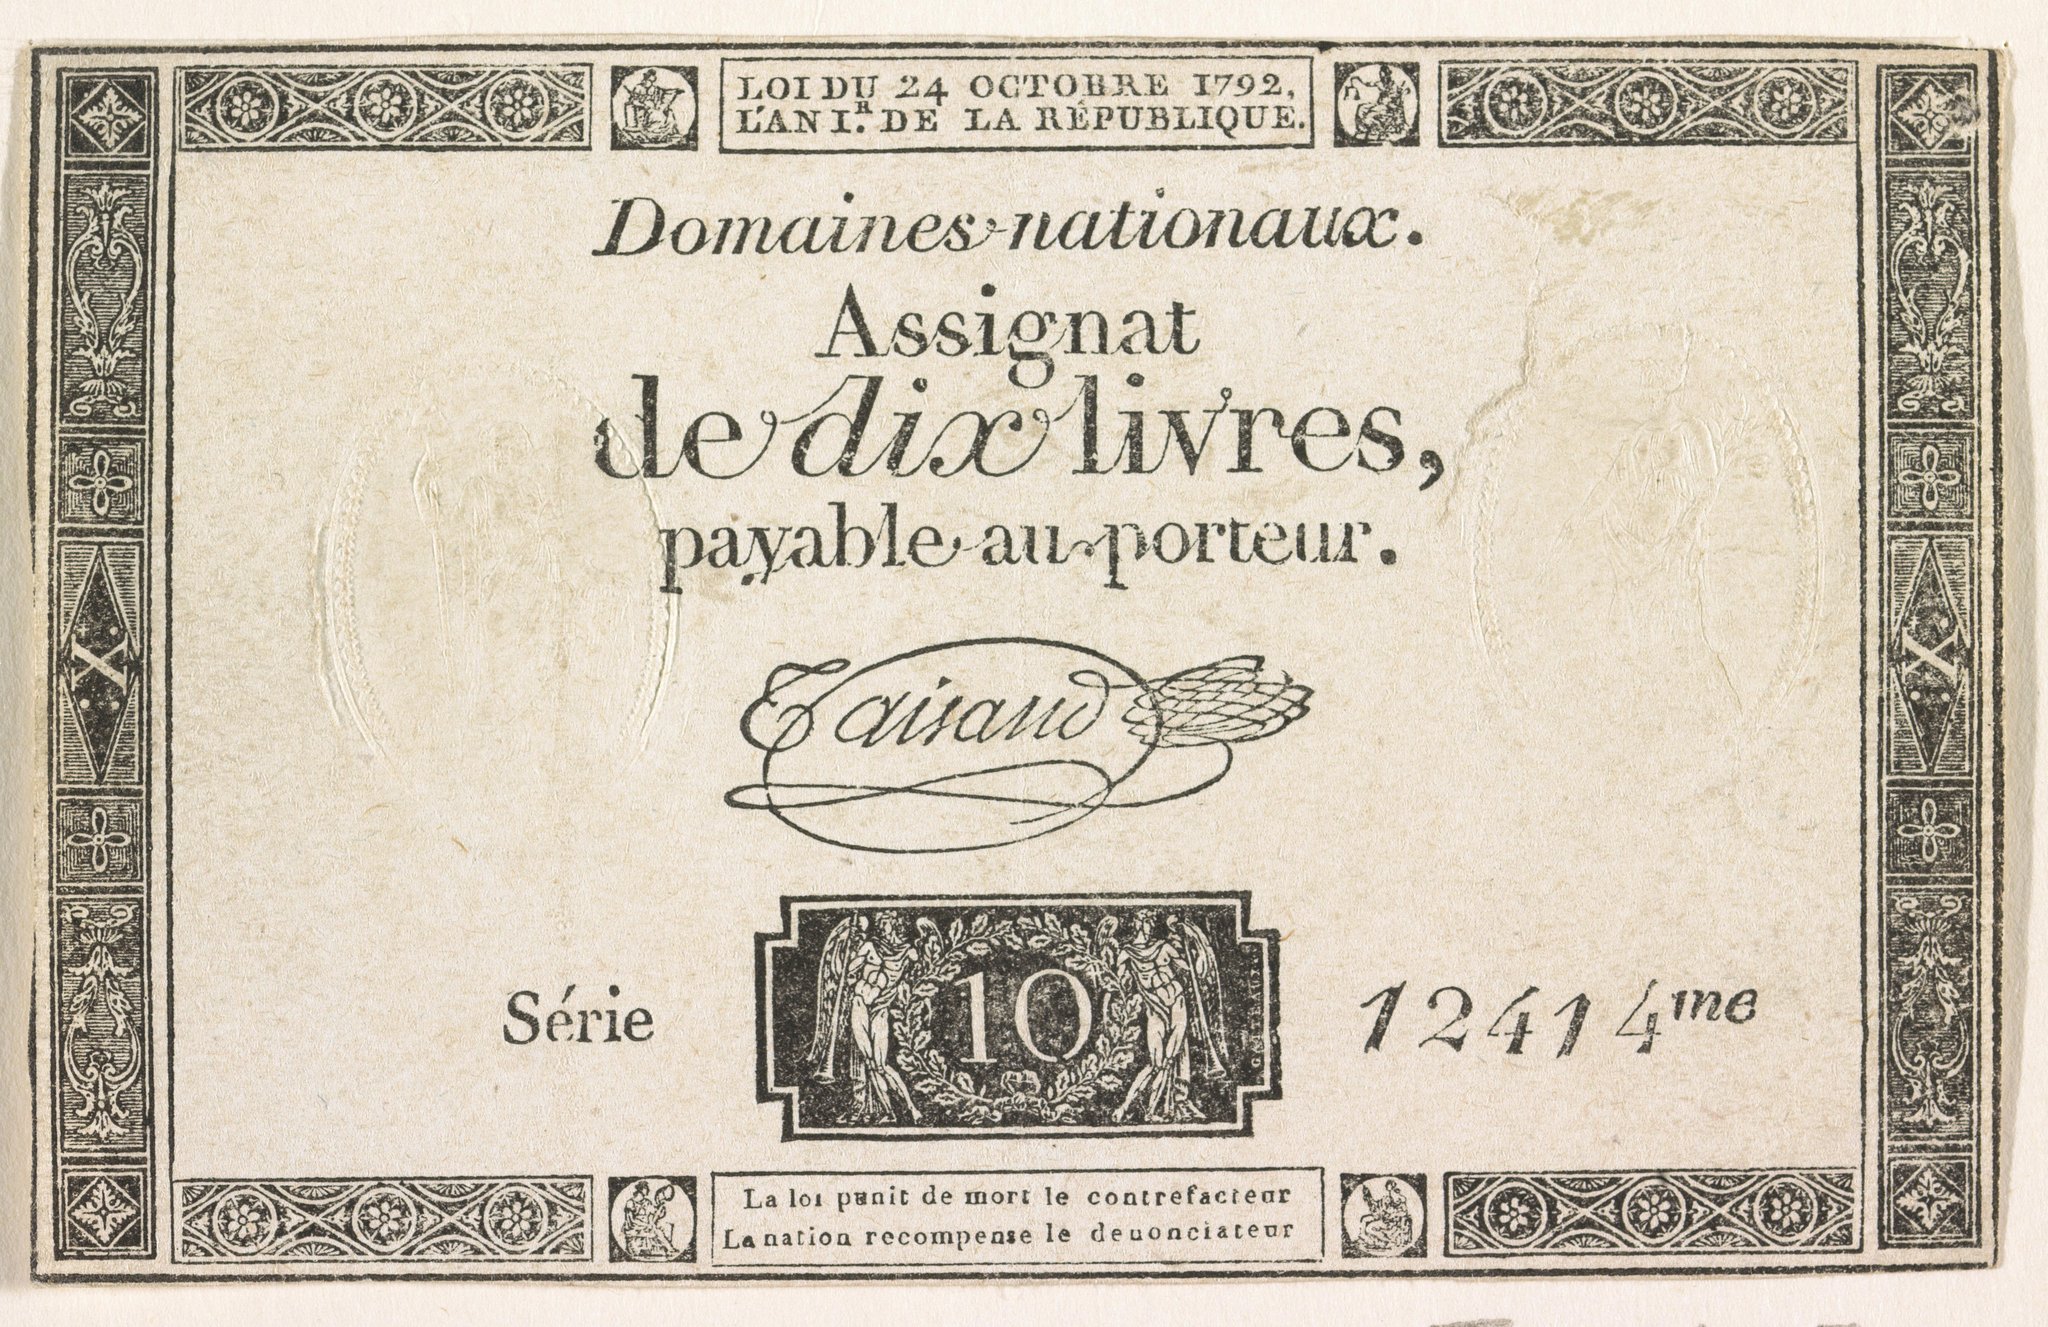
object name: assignat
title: Assignat de dix livres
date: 1792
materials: paper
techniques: blind stamped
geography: france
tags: bank-note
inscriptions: collector's mark: Lugt 2228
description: Assignaat van 10 livres. In omloop gebracht door de Domaines nationaux, serie 12414, volgens de wet van 24 oktober 1792.